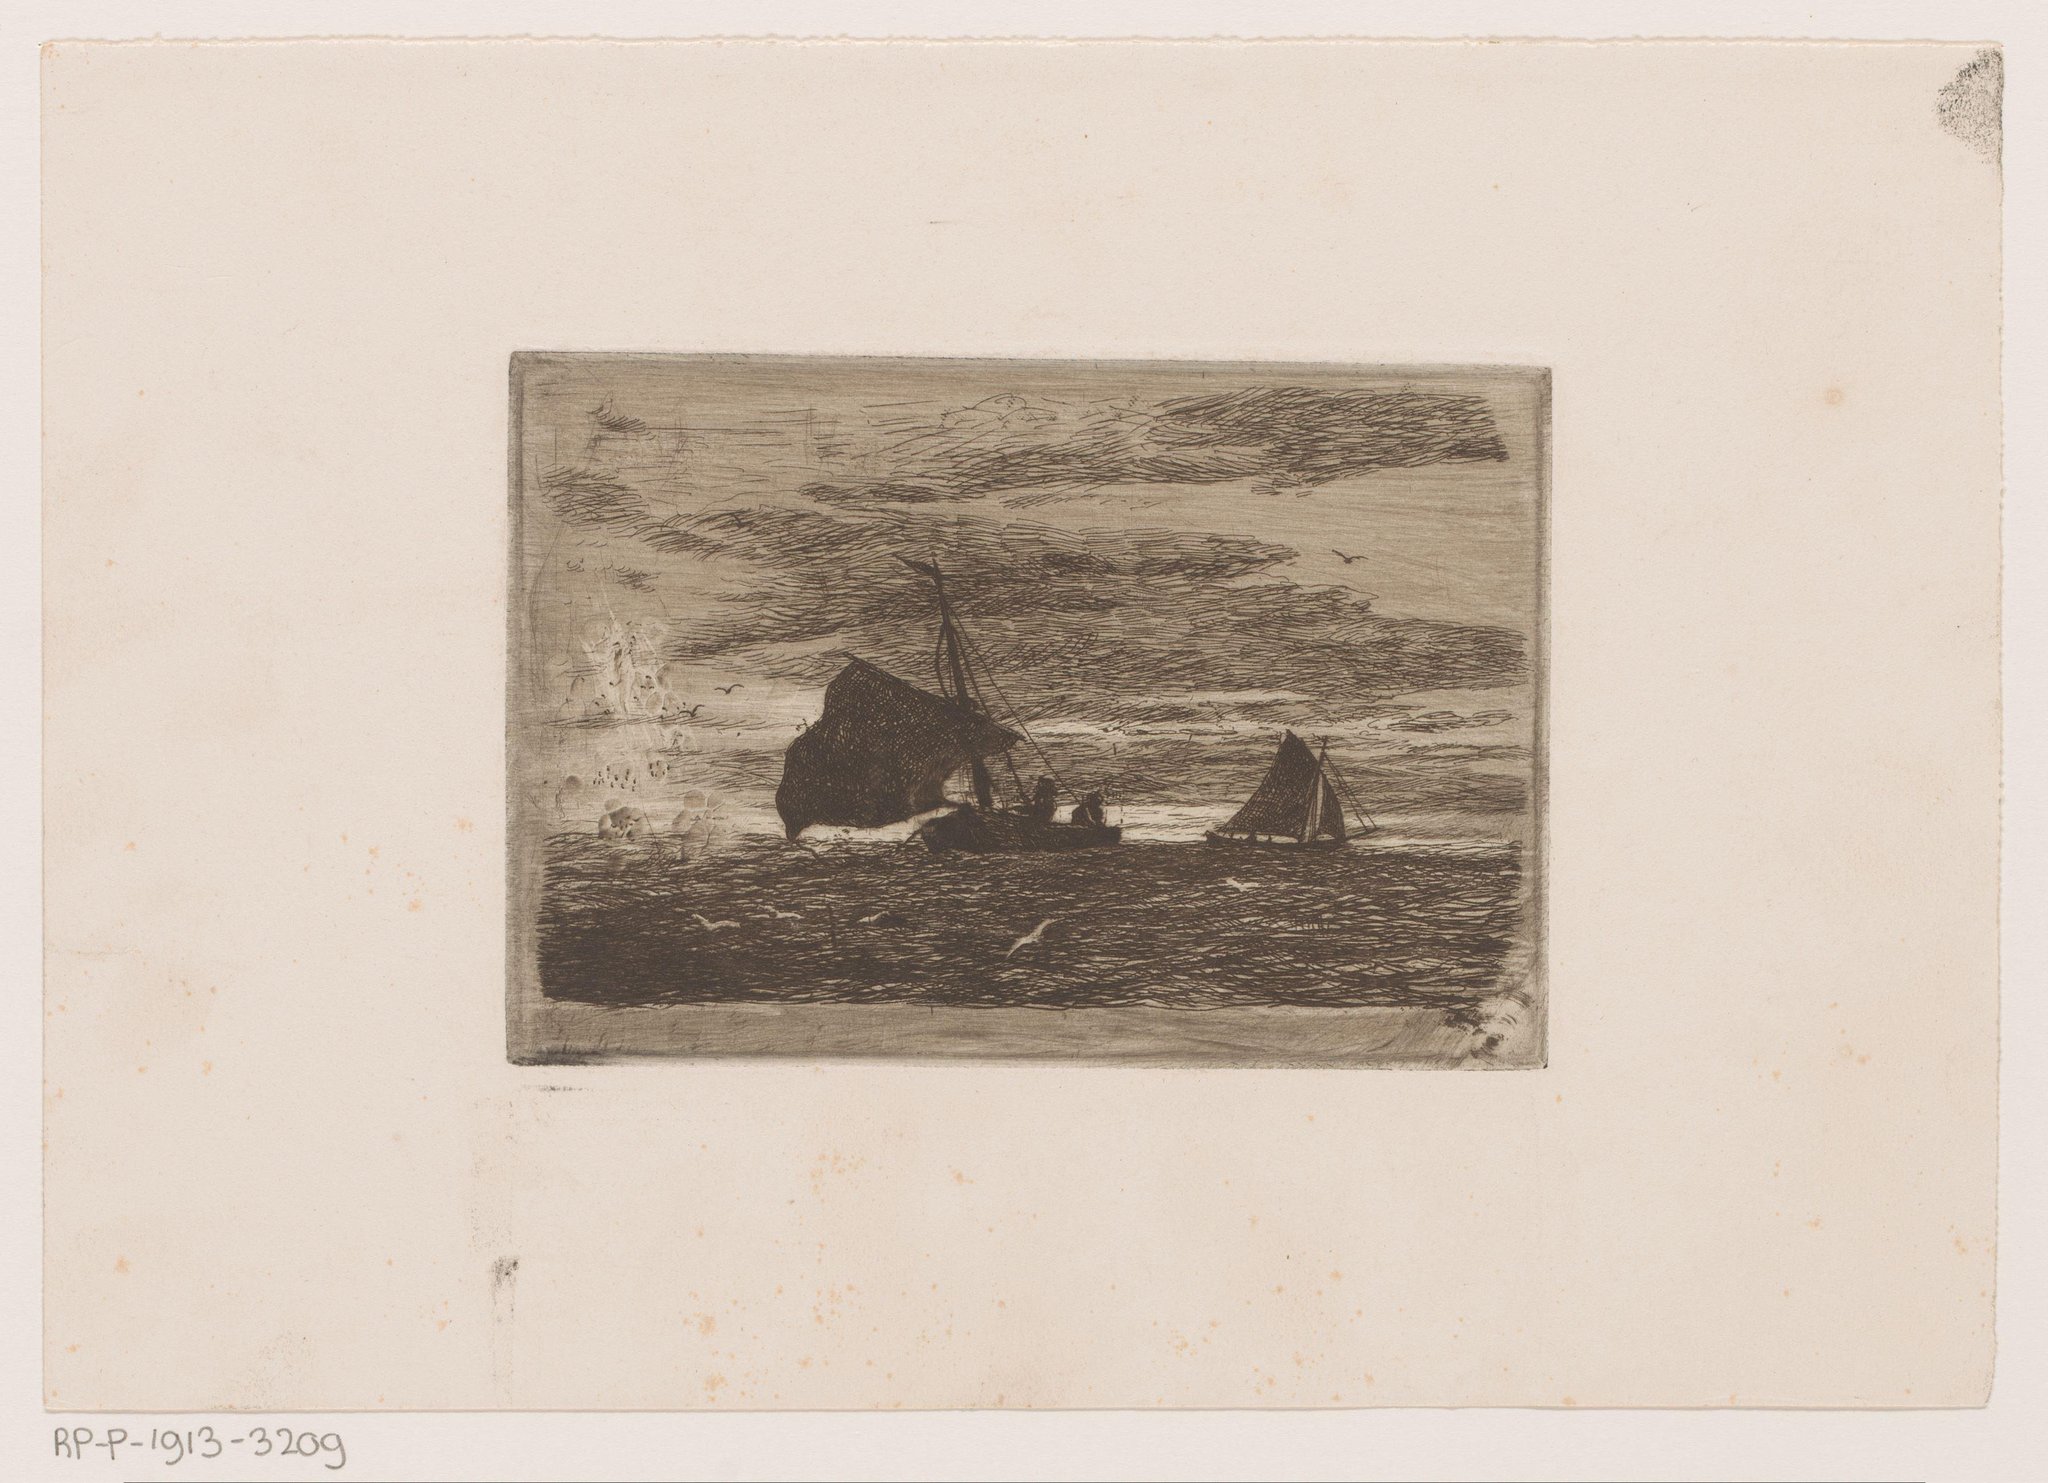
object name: print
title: Zeegezicht met twee zeilschepen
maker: jerôme tuyttens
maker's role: painter, print maker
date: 1850-1883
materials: paper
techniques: drypoint, etching, intaglio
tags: sailing-ship, sailing-boat, sea (seascape)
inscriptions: collector's mark: Lugt 2228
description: Sterfdatum van de prentmaker is onbekend. Daarom is voor de bepaling van de rechten van dit object gebruik gemaakt van de verwervingsdatum Rijksmuseum Amsterdam.